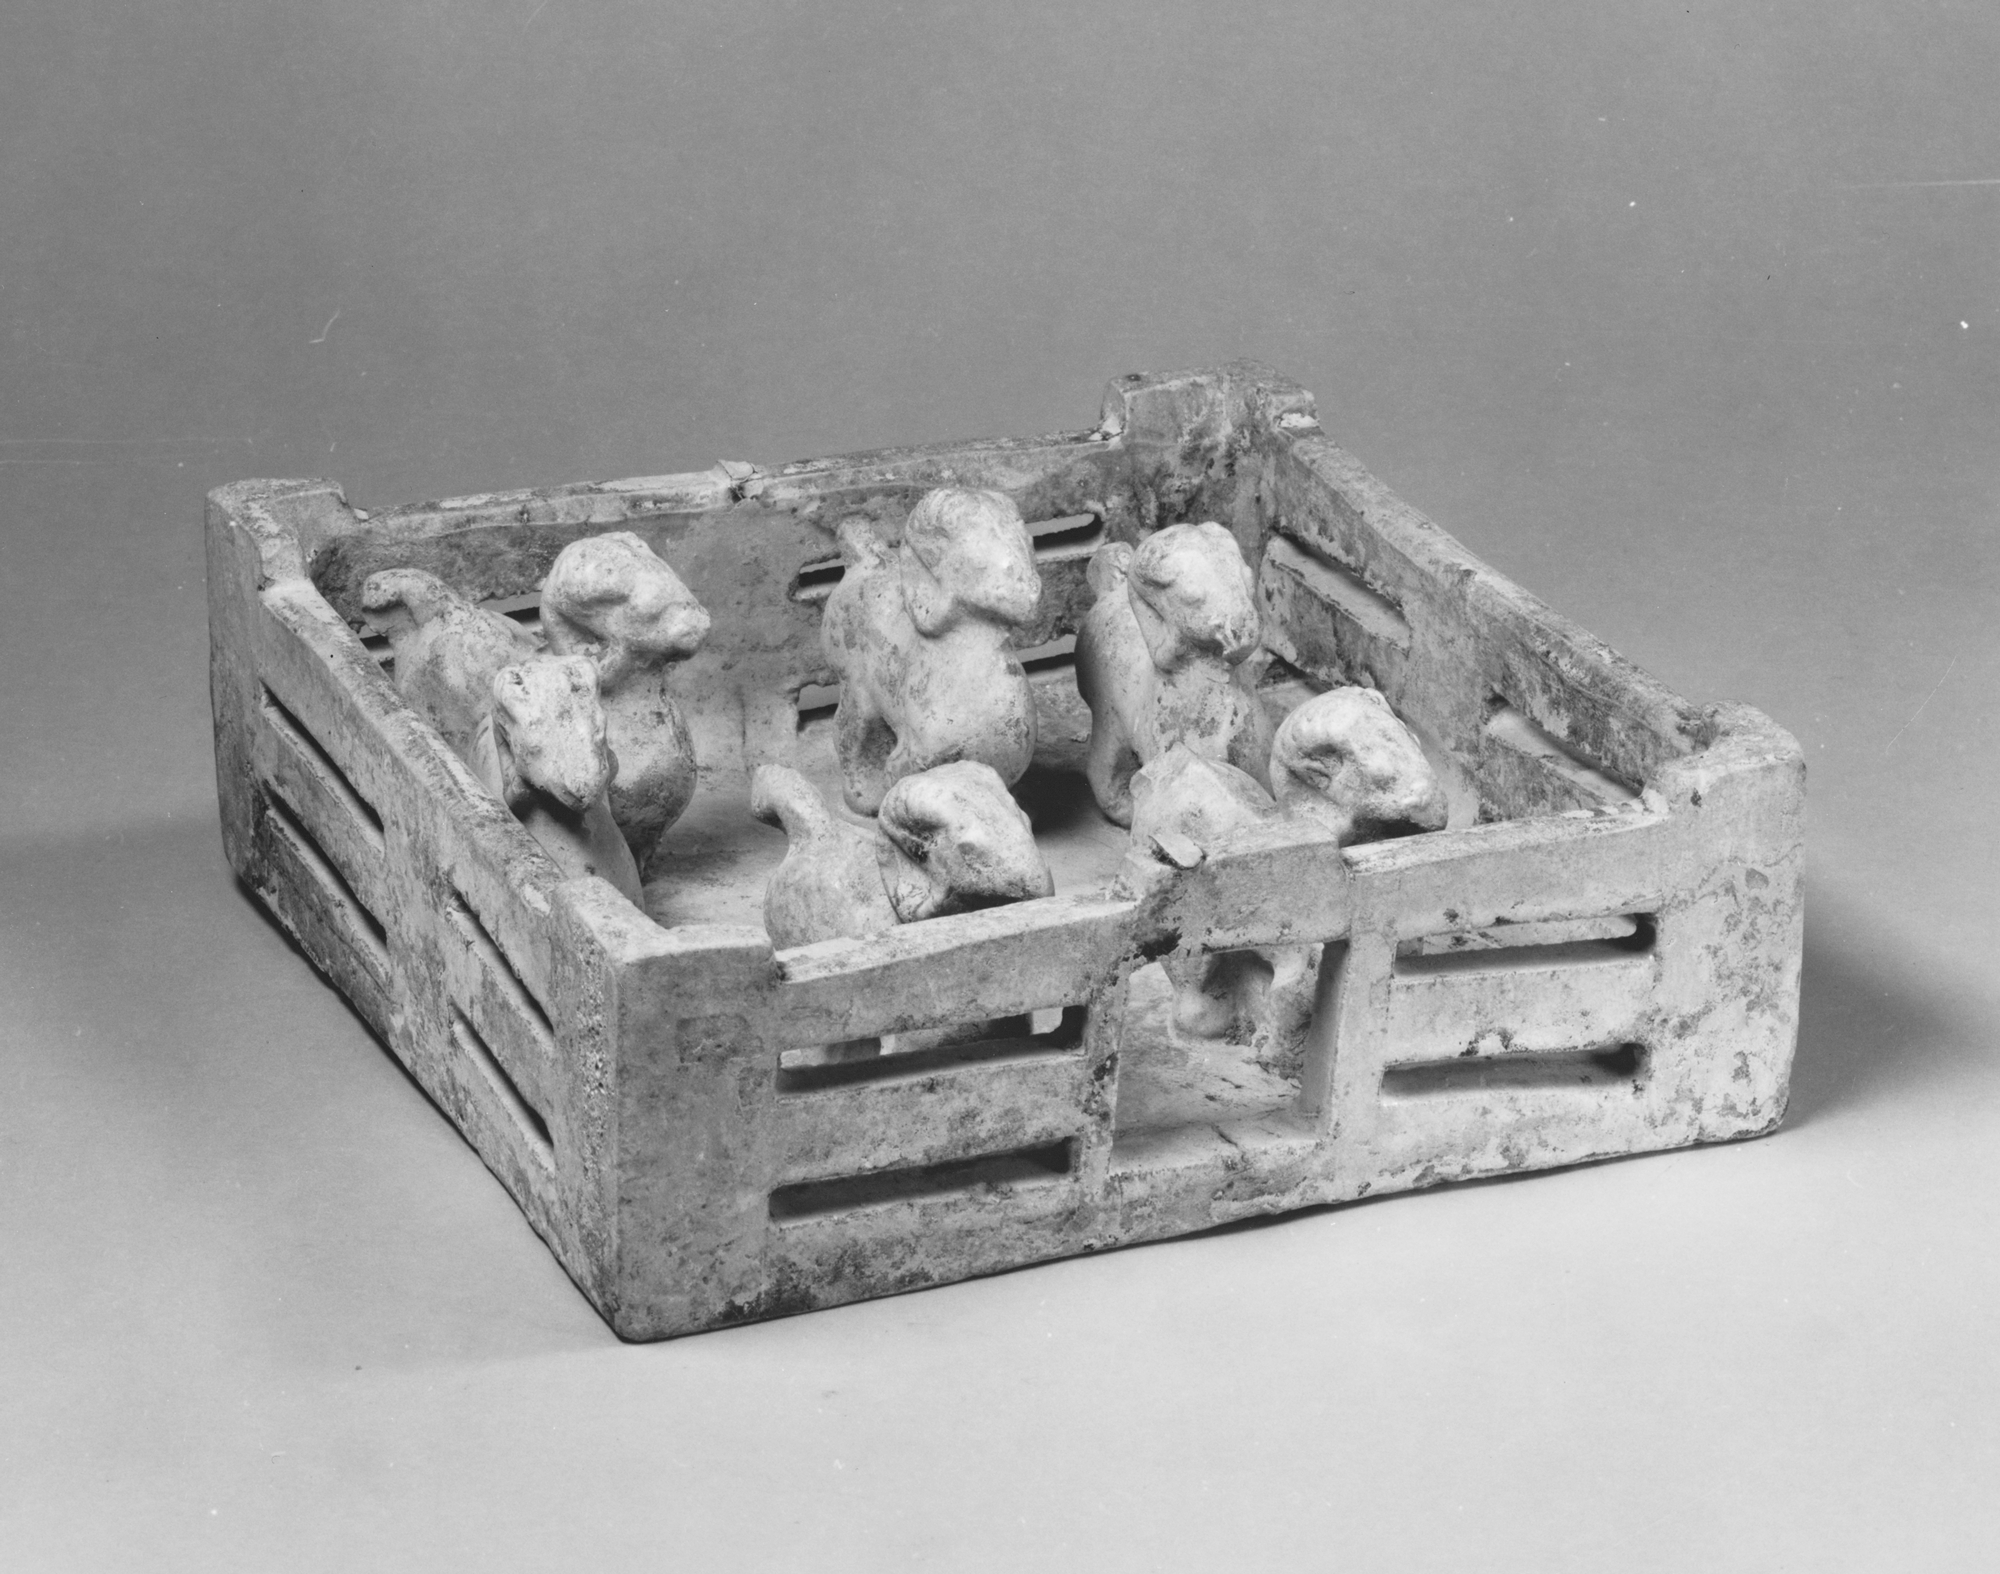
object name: architectural model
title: Square Pen with Six Rams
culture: chinese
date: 1-233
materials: earthenware, glaze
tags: rams